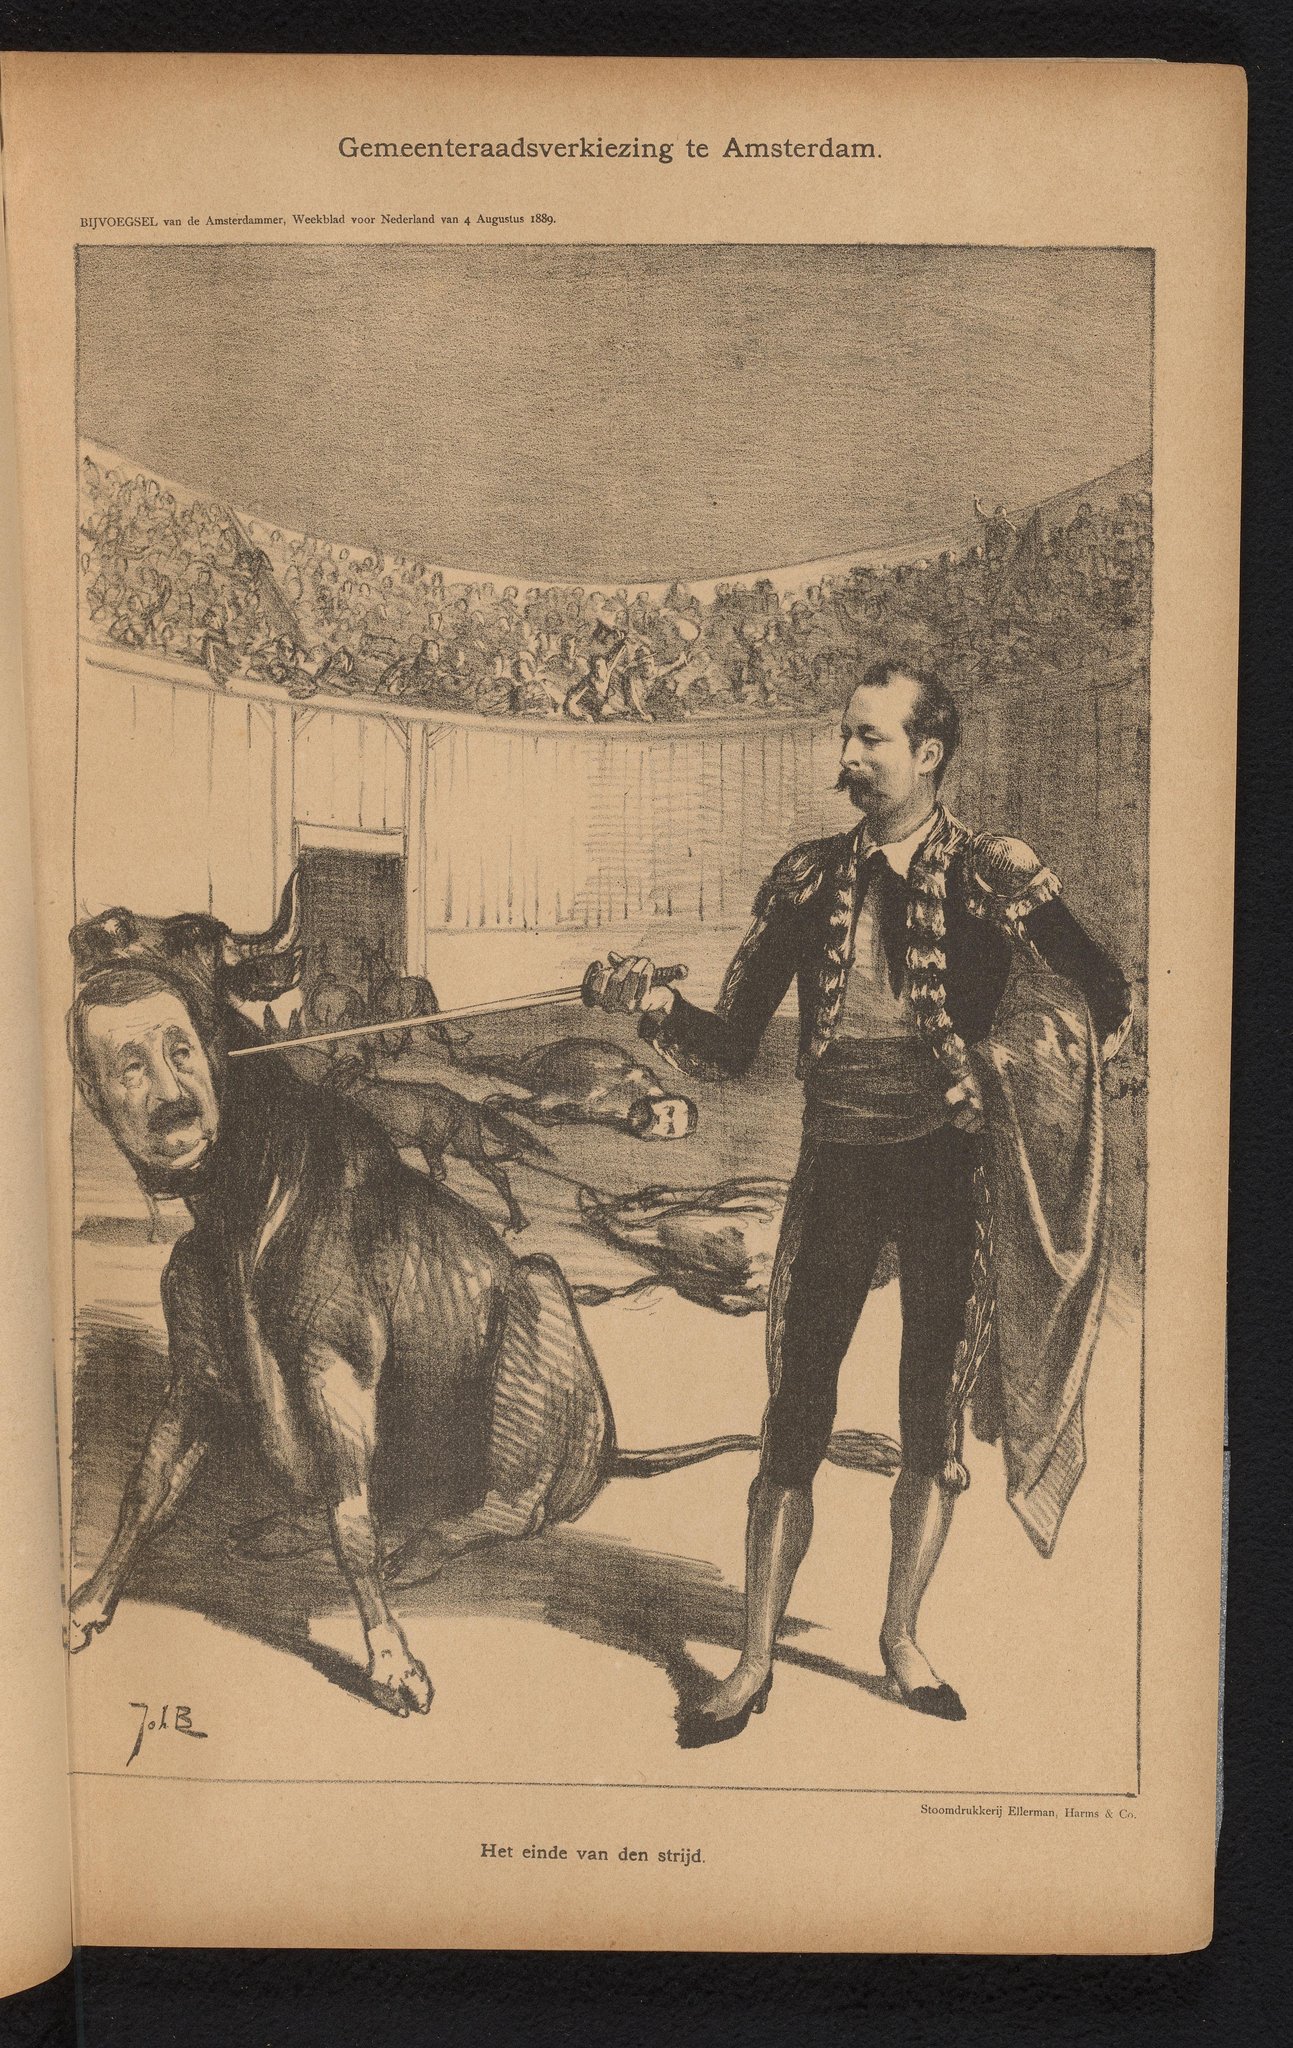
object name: cartoon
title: Gemeenteraadsverkiezing te Amsterdam / Het einde van den strijd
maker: johan braakensiek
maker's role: draughtsman, print maker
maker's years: 1858-1940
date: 1889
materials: paper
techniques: lithograph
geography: amsterdam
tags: voting, election, bullfight, municipal government, political caricatures and satires, amsterdam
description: De Gemeenteraadsverkiezingen van Amsterdam van 16 juli 1889 voorgesteld als stierengevecht met de matador als de winnaar van de verkiezingen die de stier, zijn tegenstander, de doodssteek toebrengt.